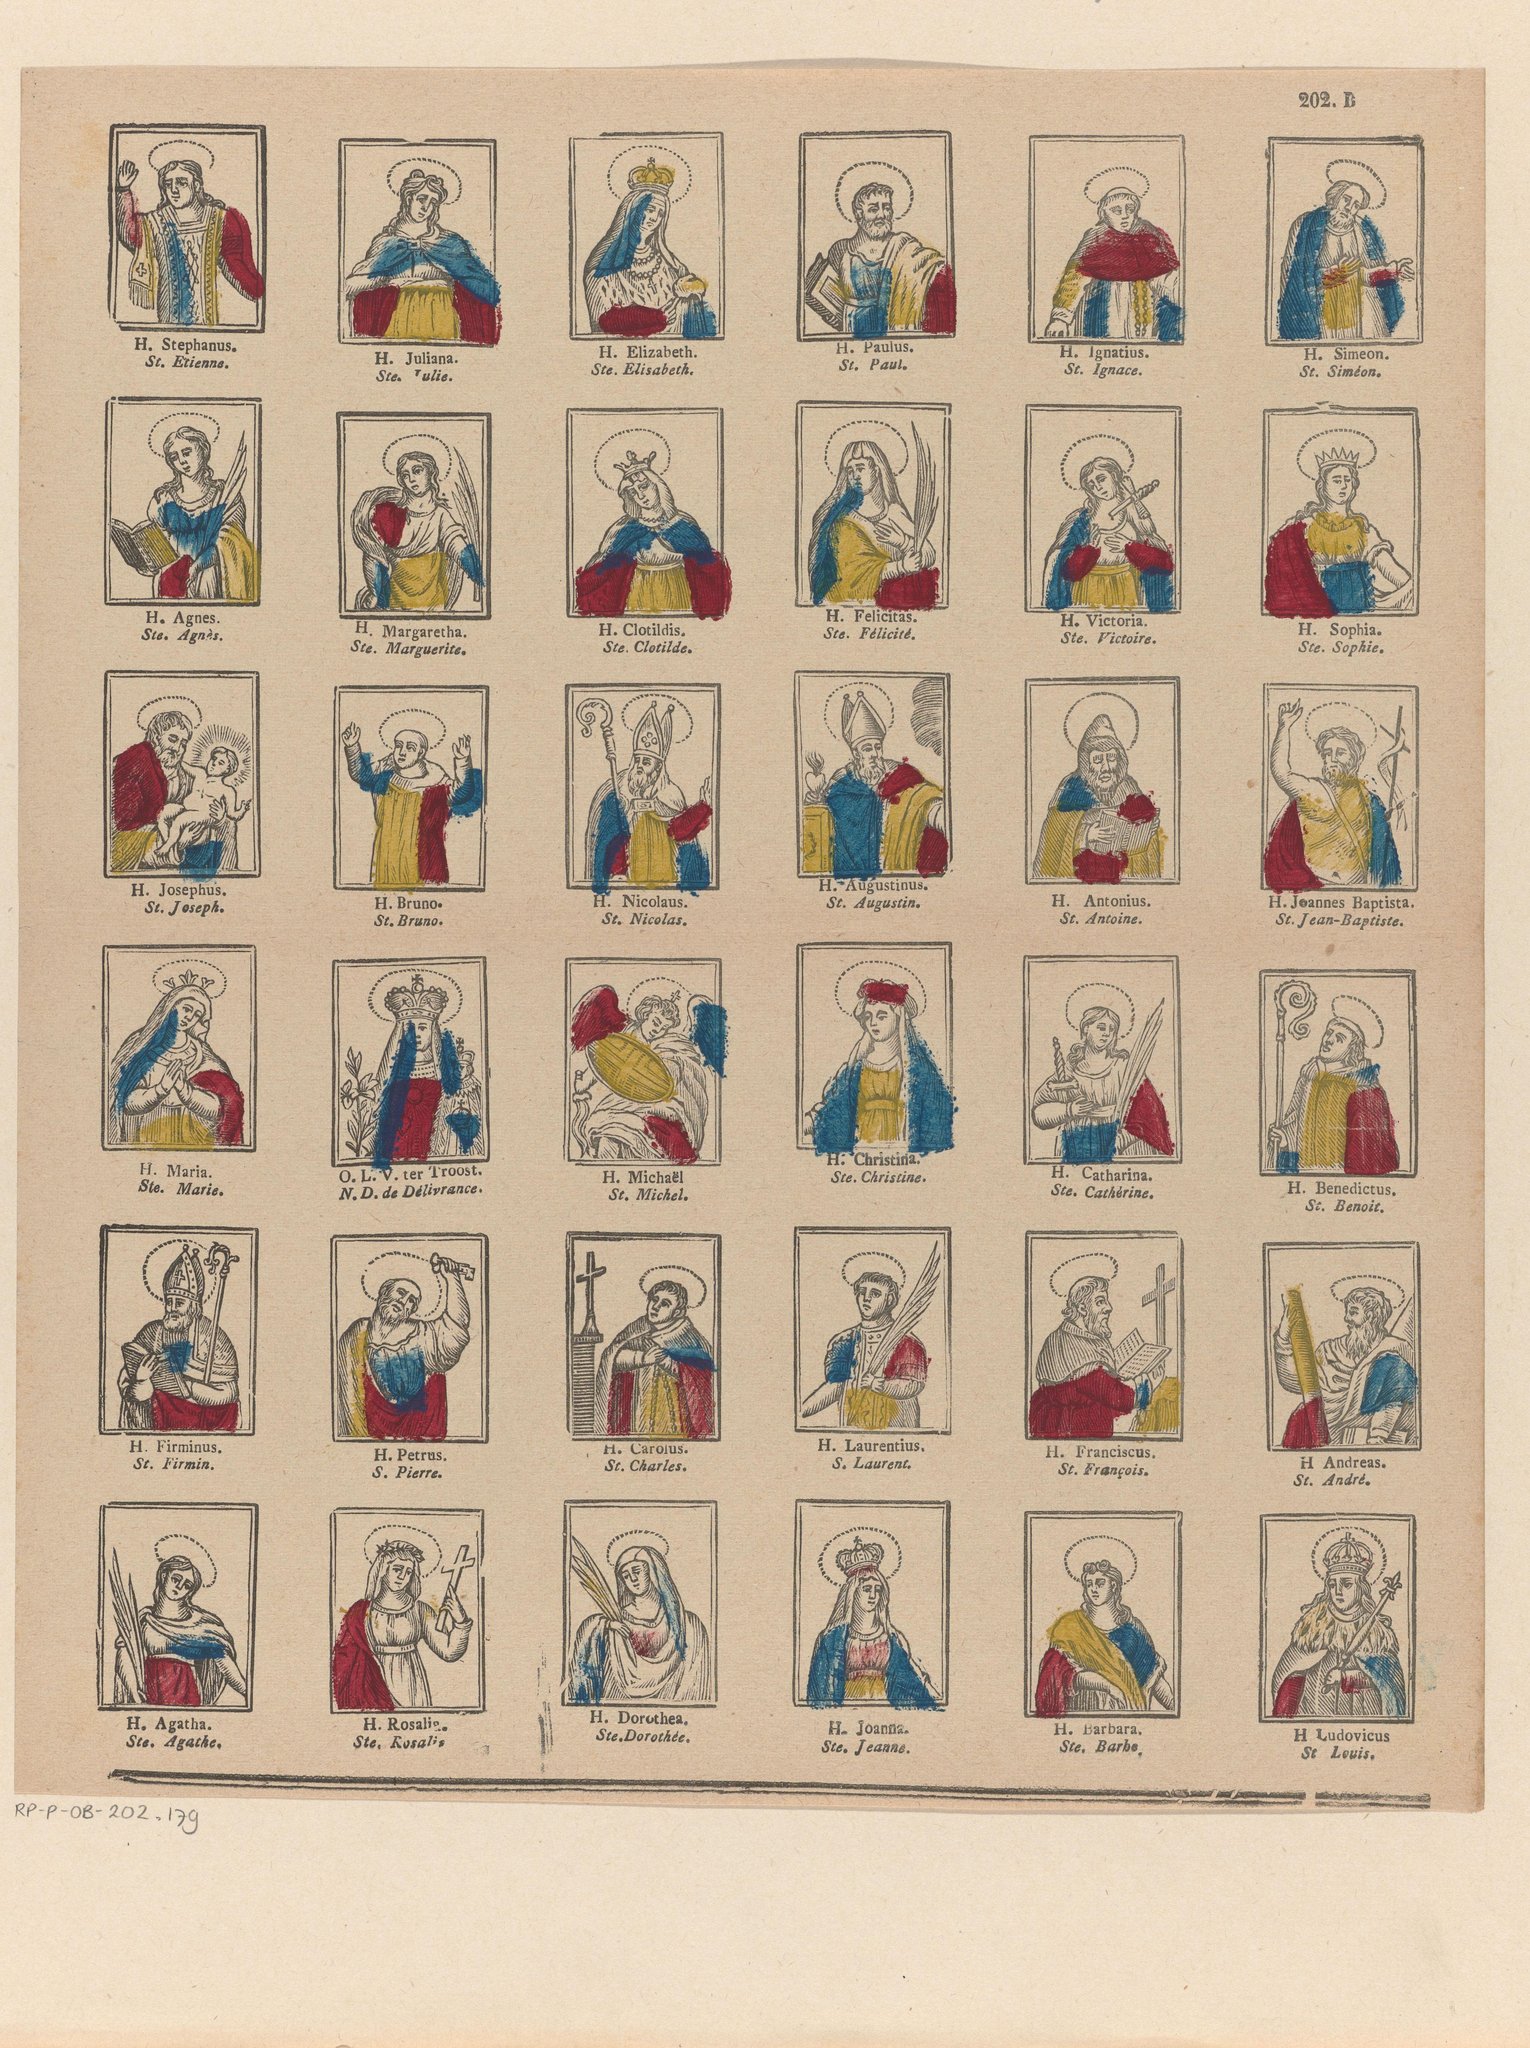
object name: print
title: Heiligen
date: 1800-1833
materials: paper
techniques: colour, letterpress printing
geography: turnhout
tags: benedict of nurcia, abbot of monte cassino and founder of the benedictine order; possible attributes: aspergillum, book, cup (sometimes broken), raven with loaf, sieve (or tray), the virgin martyr agnes of rome; possible attributes: lamb, ring, the virgin martyr margaret of antioch; possible attributes: cross, crown, dragon (under feet or on chain), (chaplet of) pearls, saints, female saints, the hermit antony abbot (antonius abbas) of egypt, also called the great; possible attributes: bell, book, t-shaped staff, flames, pig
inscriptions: collector's mark: Lugt 2760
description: Blad met 36 voorstellingen van heiligen, waaronder St. Agnes, St. Augustinus, St. Anthonius en Johannes de Doper. Onder elke voorstelling een onderschrift in het Nederlands en in het Frans. Genummerd rechtsboven: 202. B.